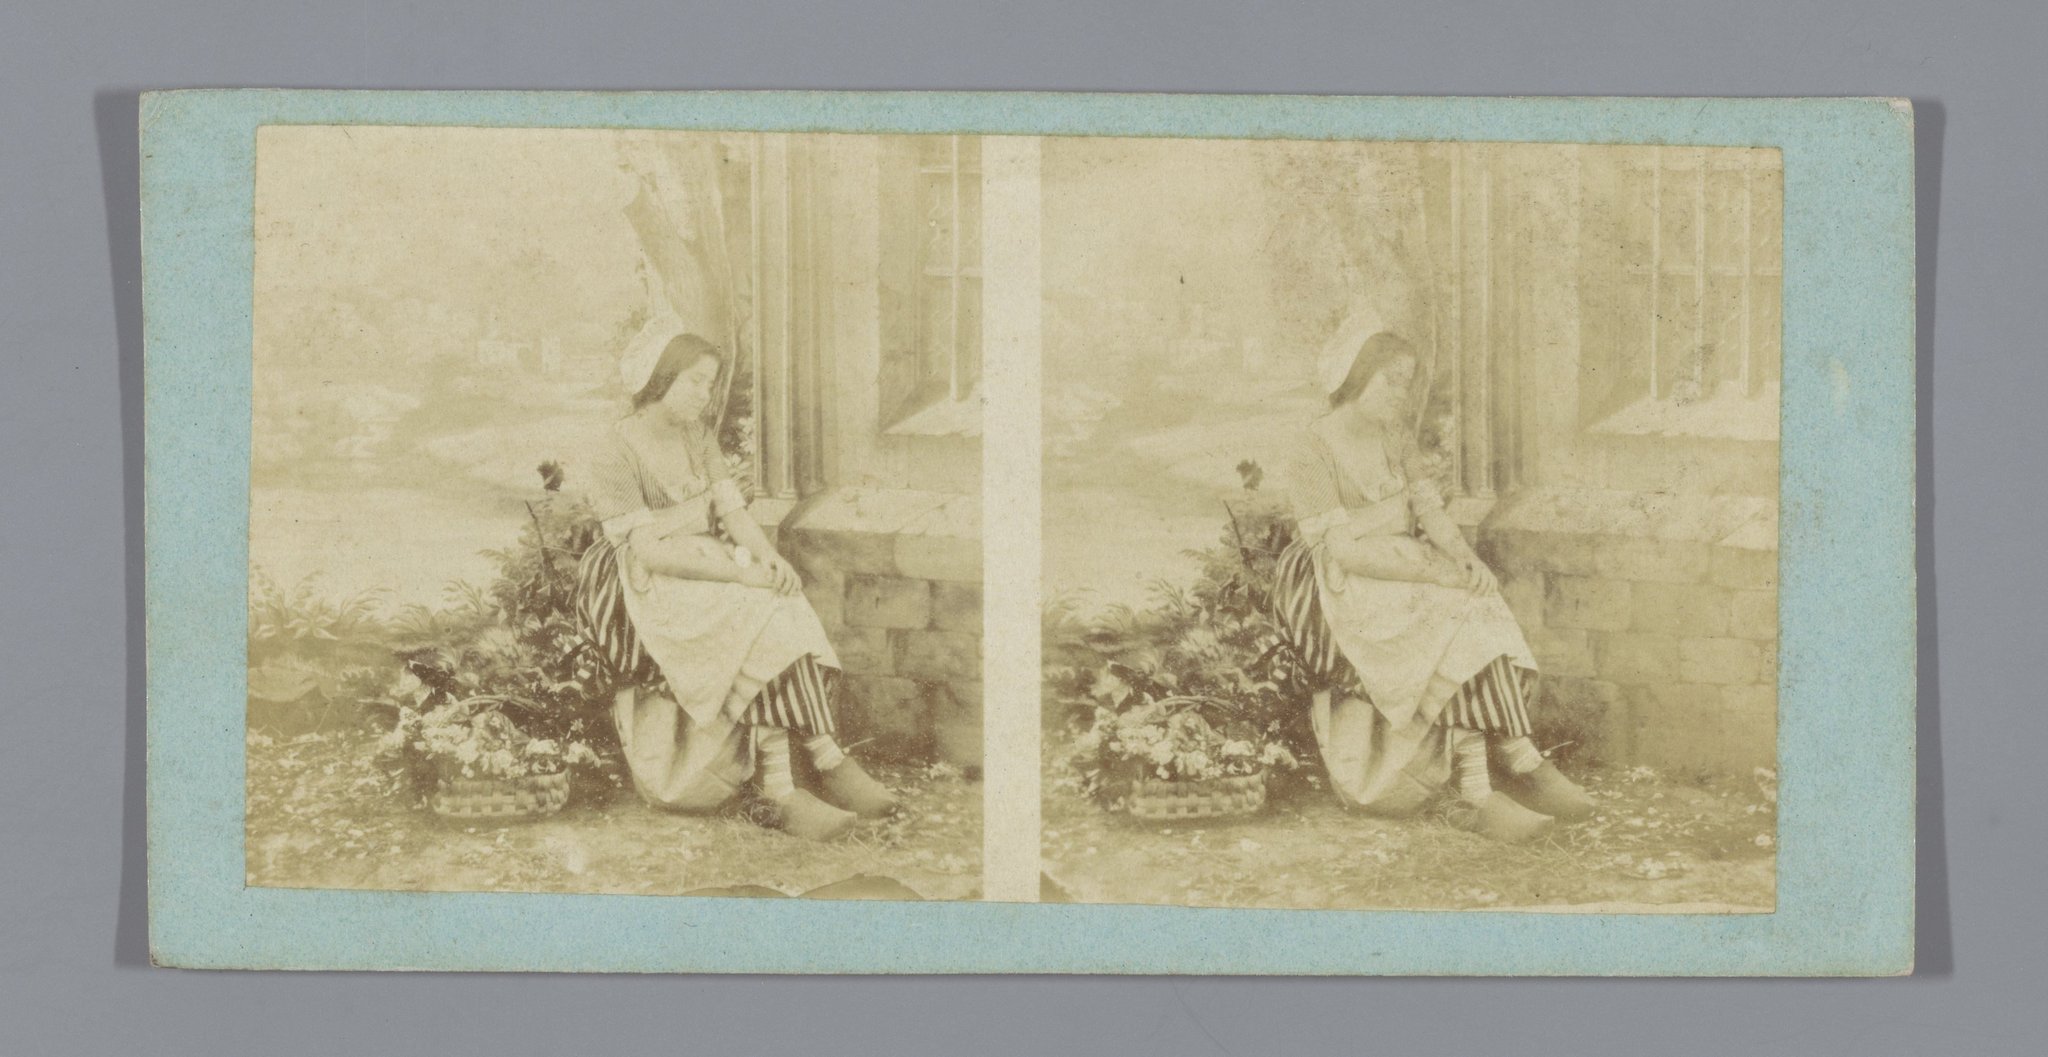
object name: stereograph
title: Theatrale voorstelling van een vrouw met klompen en bloemenmand voor een decor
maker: Anonymous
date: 1850-1880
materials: cardboard, photographic support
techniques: albumen print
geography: europe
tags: cut flowers; nosegay, bunch of flowers, backdrop, wooden shoes, clogs, europe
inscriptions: inscription: ‘fotos’